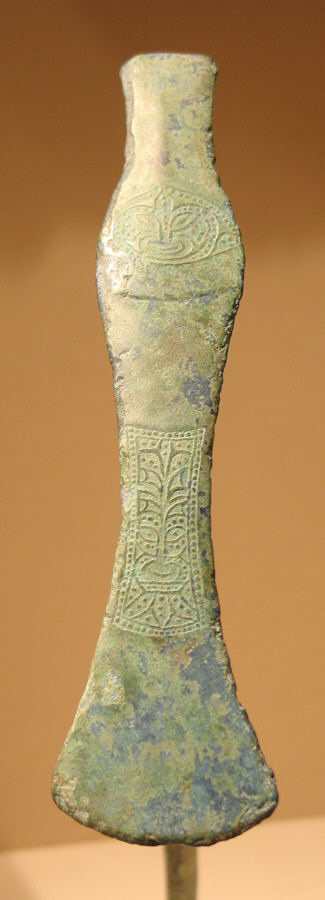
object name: hafted ax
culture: indonesian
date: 500 BCE-300 CE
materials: bronze